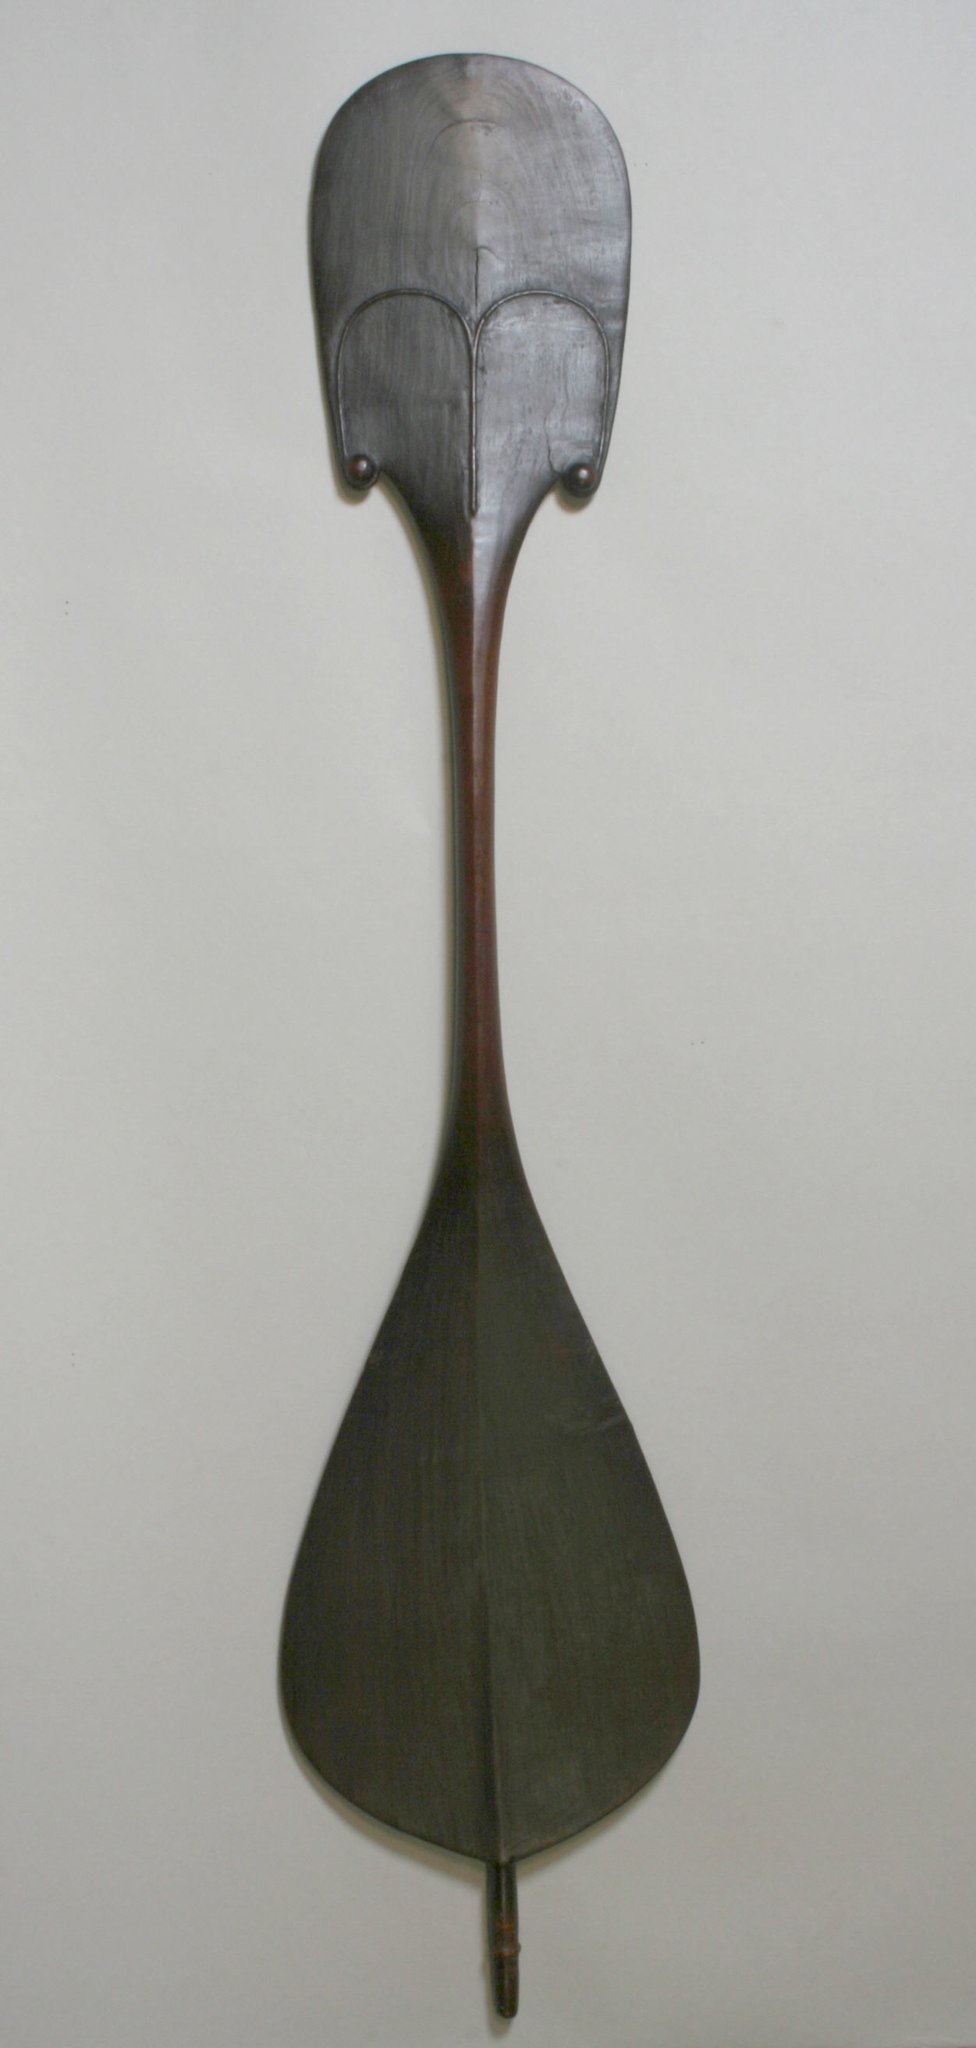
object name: dance paddle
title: Dance Paddle (Rapa)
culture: rapa nui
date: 1801-1833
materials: wood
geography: chile